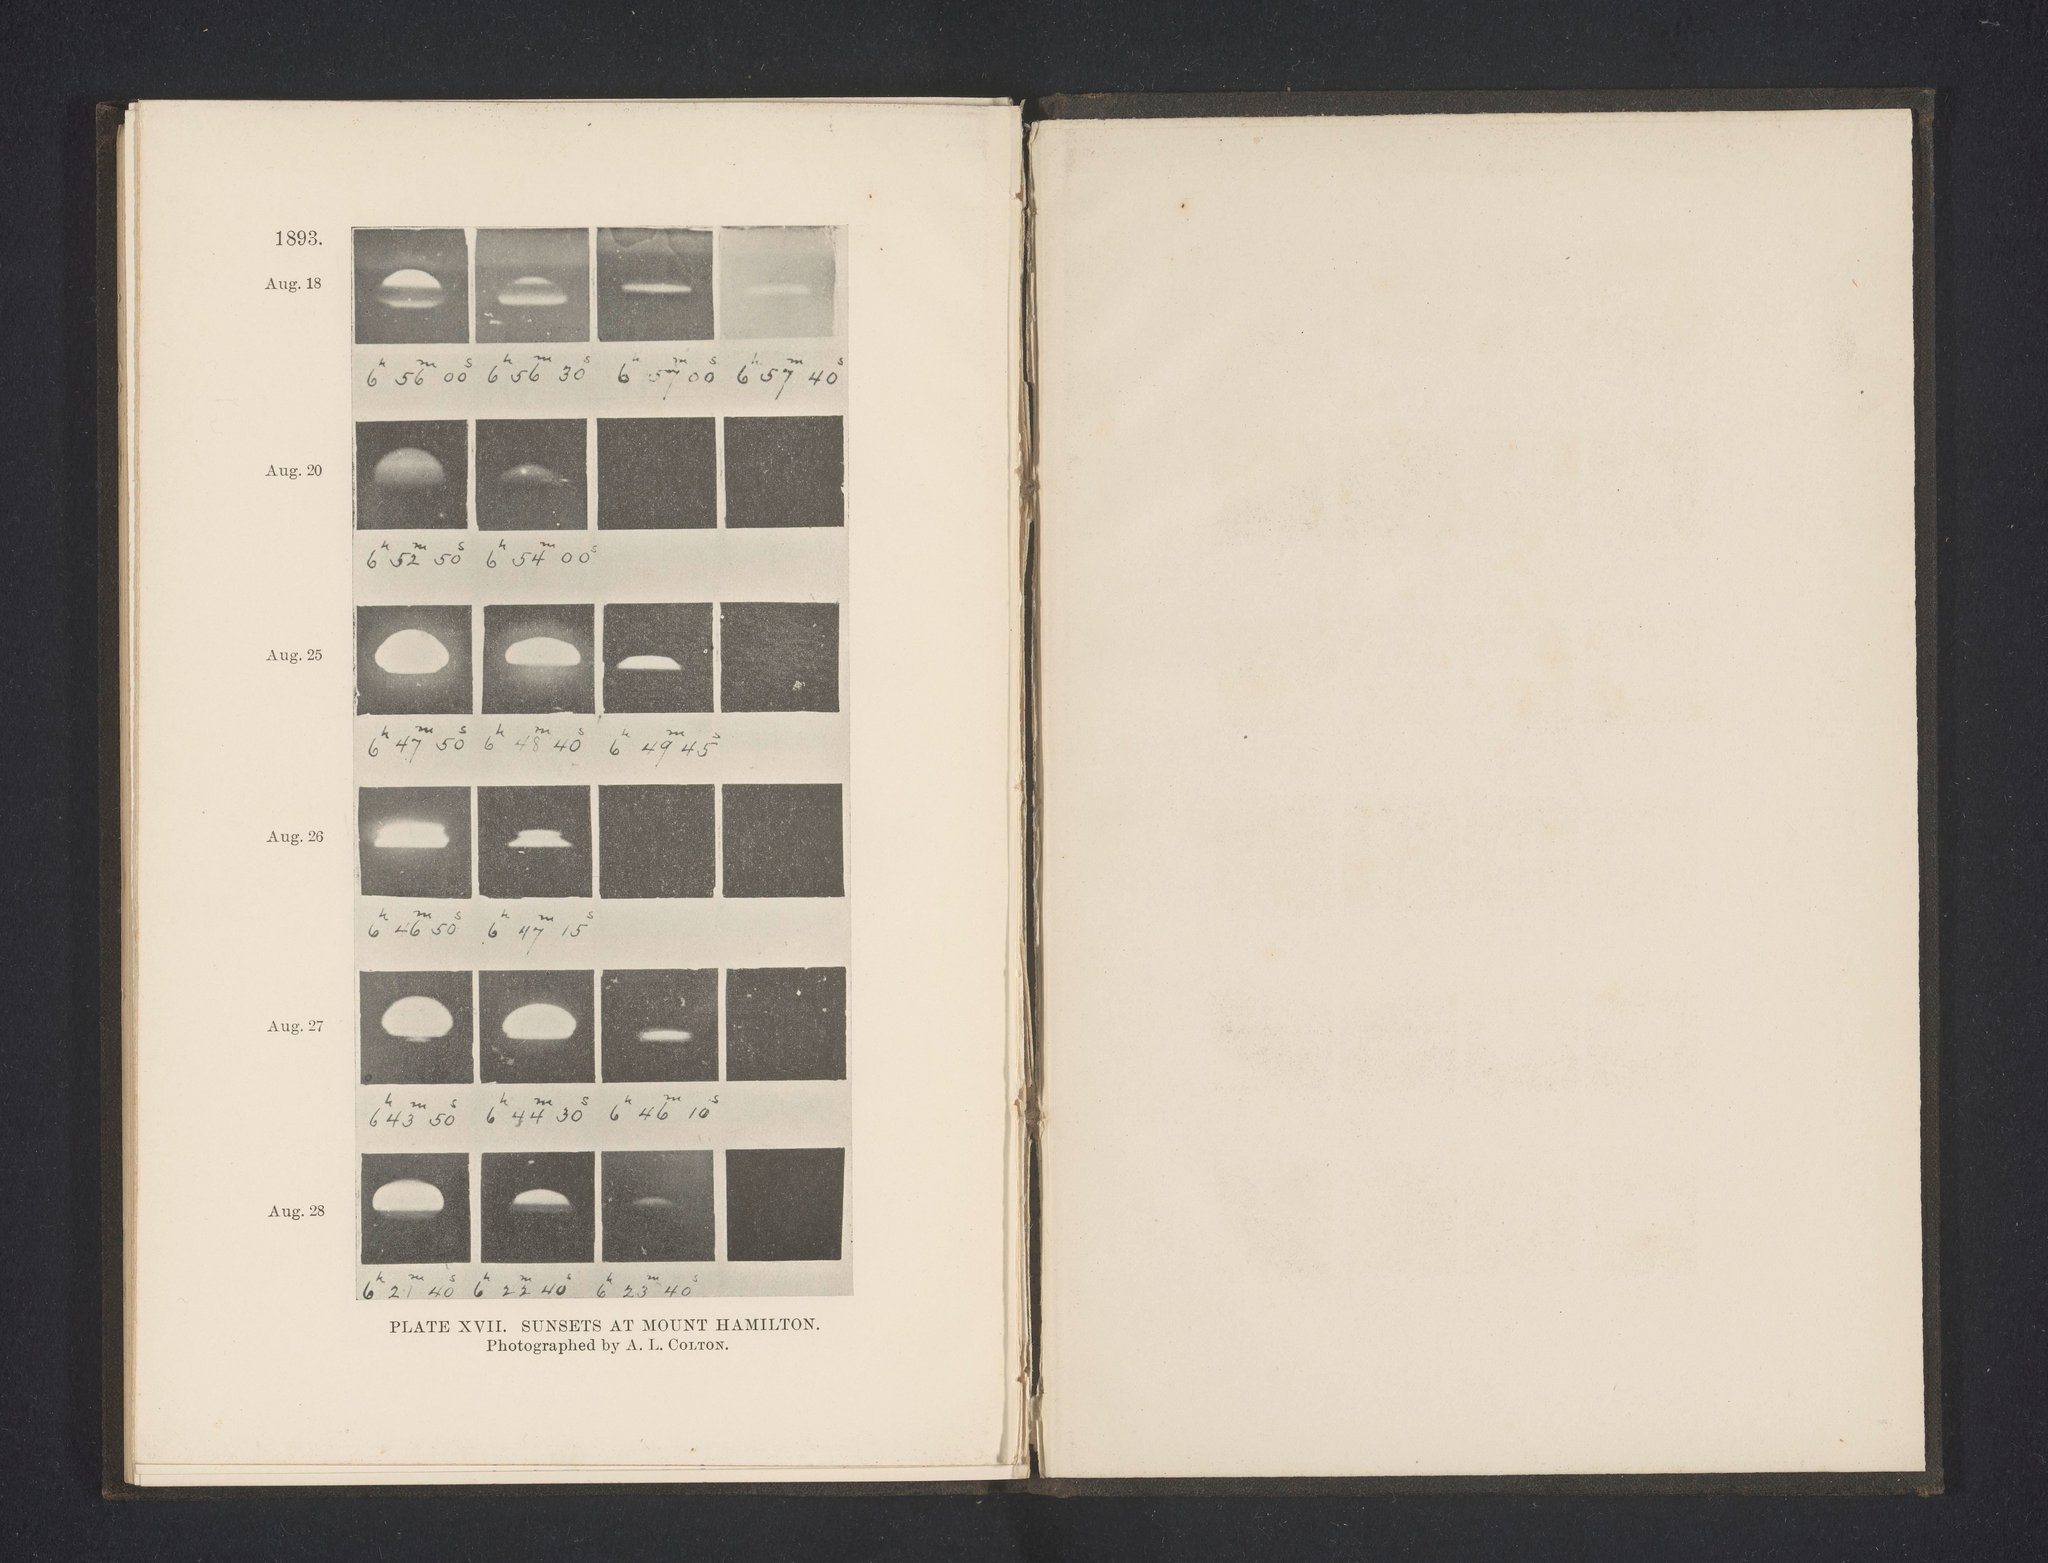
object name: photomechanical print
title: Overzicht van het verloop van de zonsondergang gezien vanaf Mount Hamilton te Californië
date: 1893-1895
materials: paper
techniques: autotype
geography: lick observatory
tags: sunset, astronomy (and cosmography)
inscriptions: date: ‘1893/ Aug. 18/ Aug. 20/ Aug. 25/ Aug. 26/ Aug. 27/ Aug. 28’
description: Prent op zesde ongenummerde pagina na pagina 86.